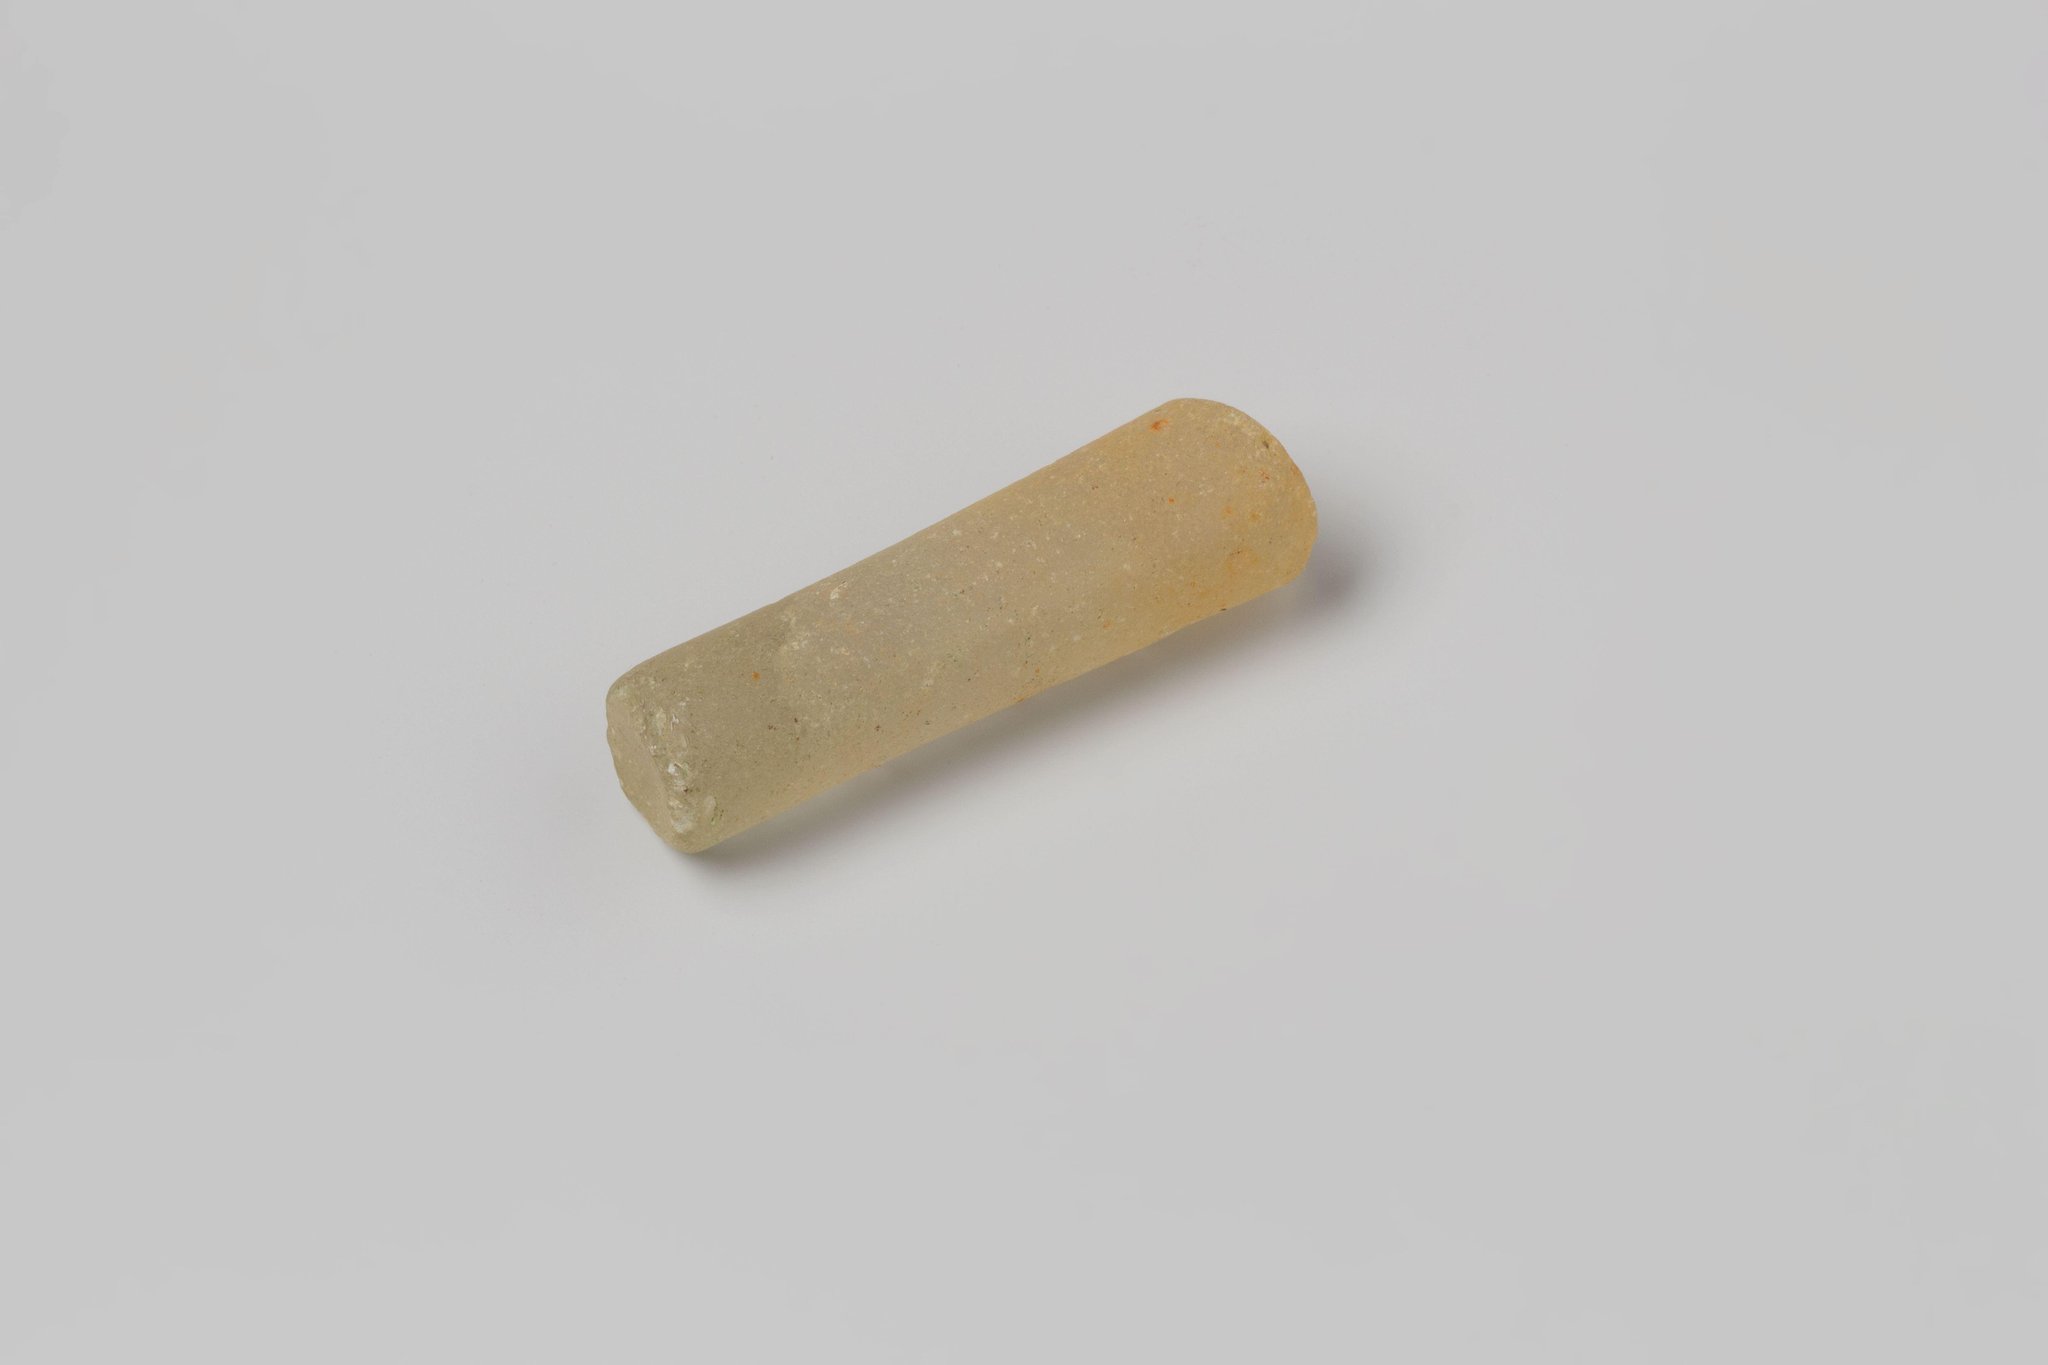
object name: helve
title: Fragment rechte steel van glas uit het wrak van de Oost-Indiëvaarder Hollandia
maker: Anonymous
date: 1700-1743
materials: glass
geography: netherlands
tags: verenigde oostindische compagnie, hollandia (schip), annet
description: Glass, stem glass, stems, plain; fragm, circular, hollow core, slightly tapering, eroded.